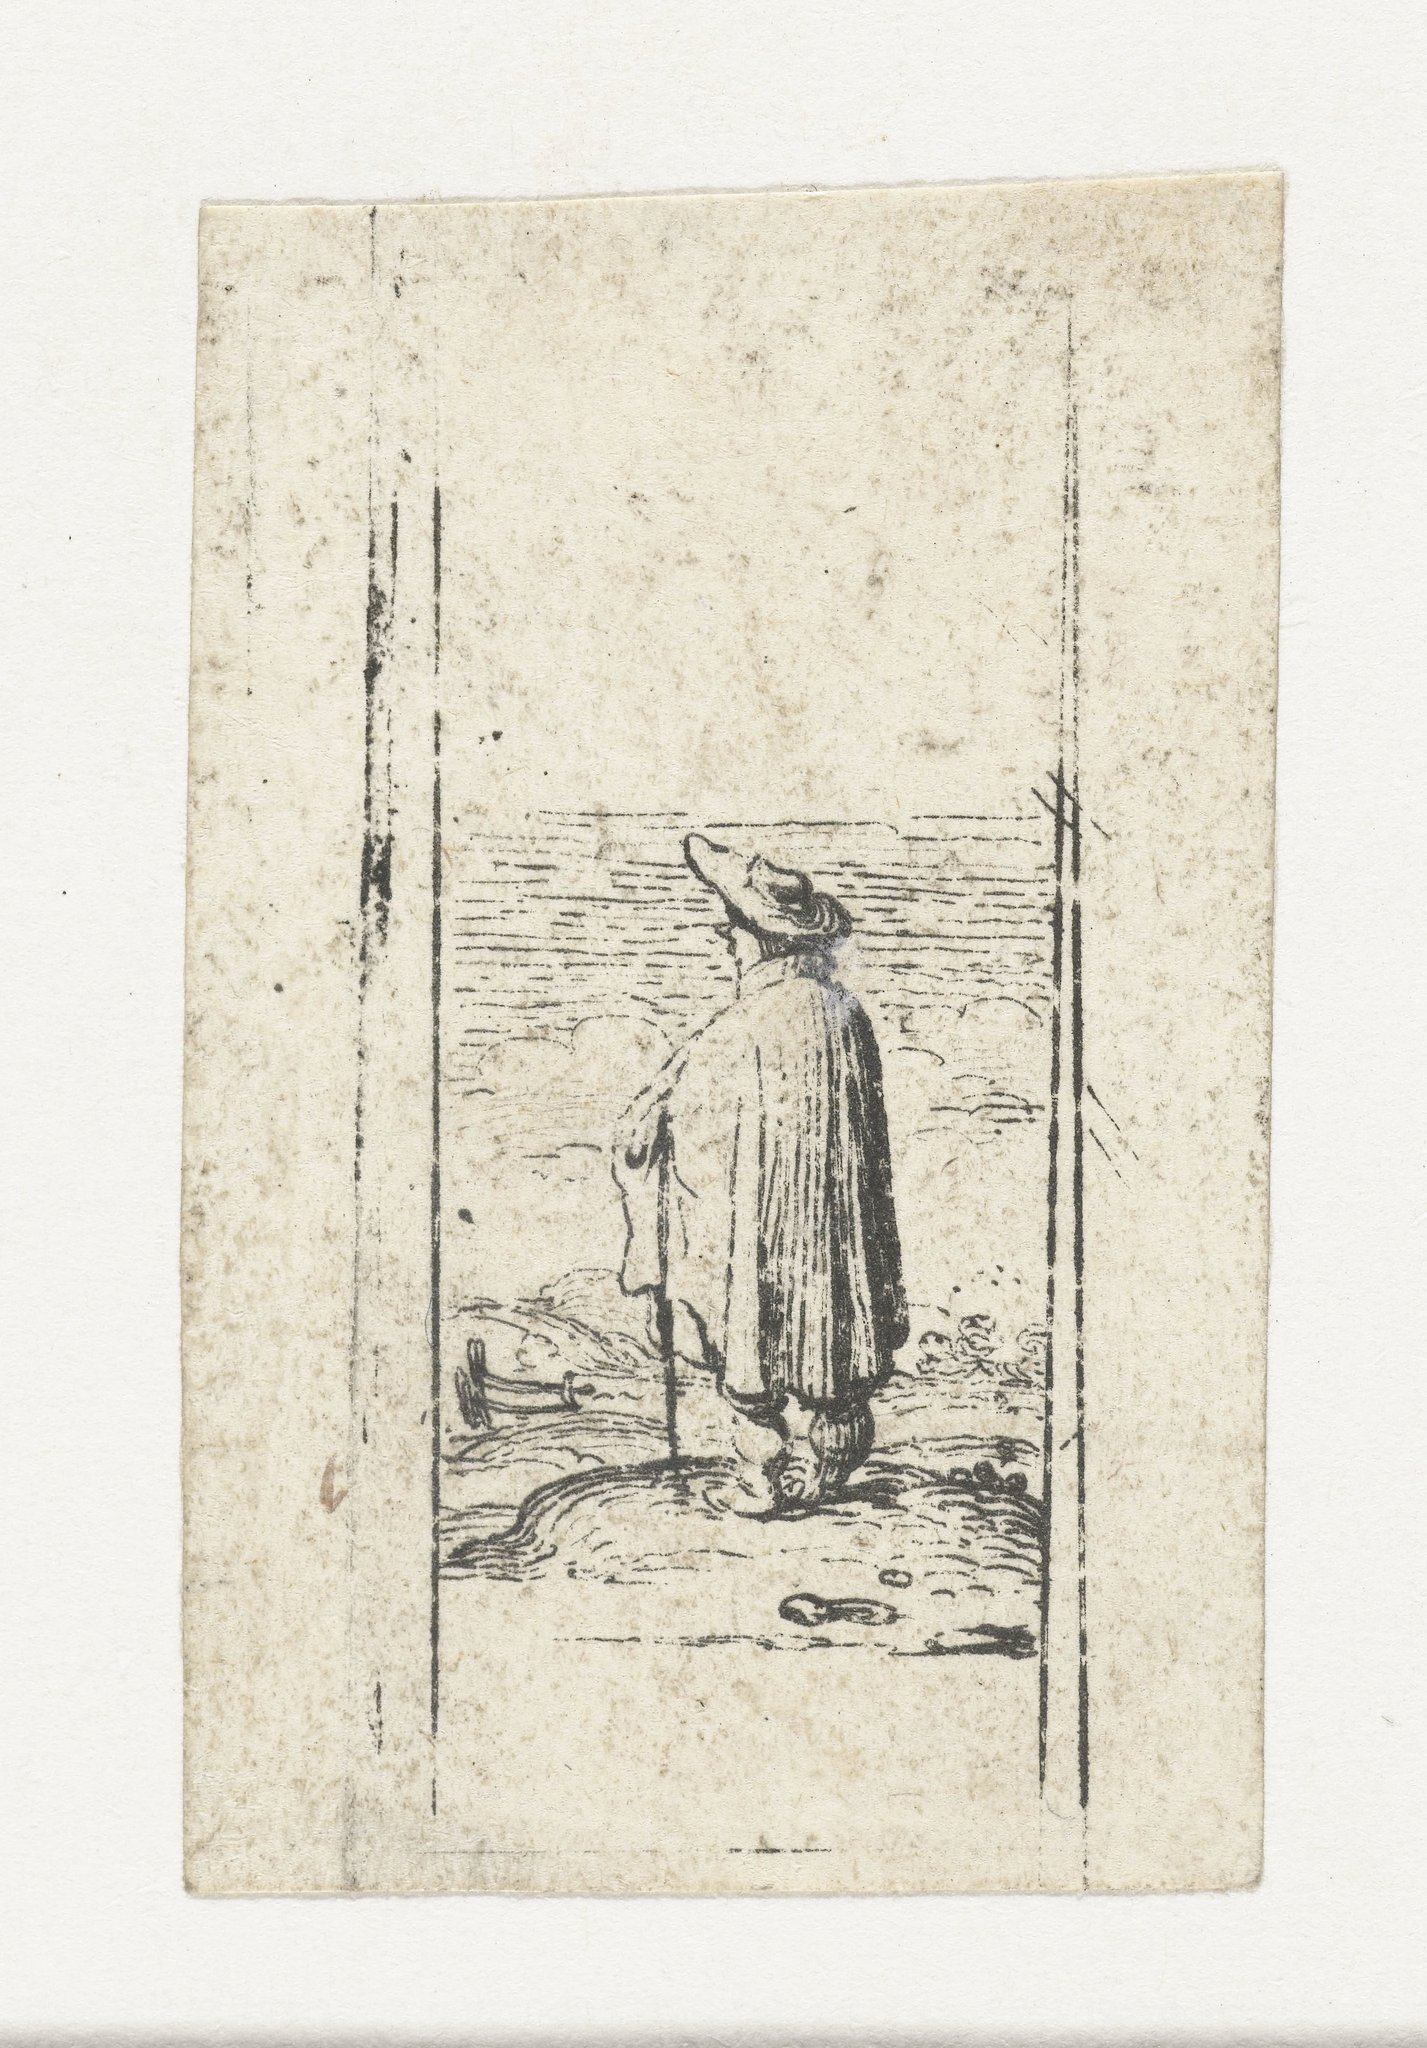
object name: print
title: Staande man in landschap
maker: gerard ter borch (i)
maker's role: draughtsman, print maker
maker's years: 1584-1662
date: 1594-1662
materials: paper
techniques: etching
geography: zwolle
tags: walking-stick, staff, mound, verge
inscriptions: collector's mark: Lugt 2228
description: Een man met een mantel en een grote hoed kijkt uit over een landschap. In zijn linkerhand heeft hij een wandelstok.